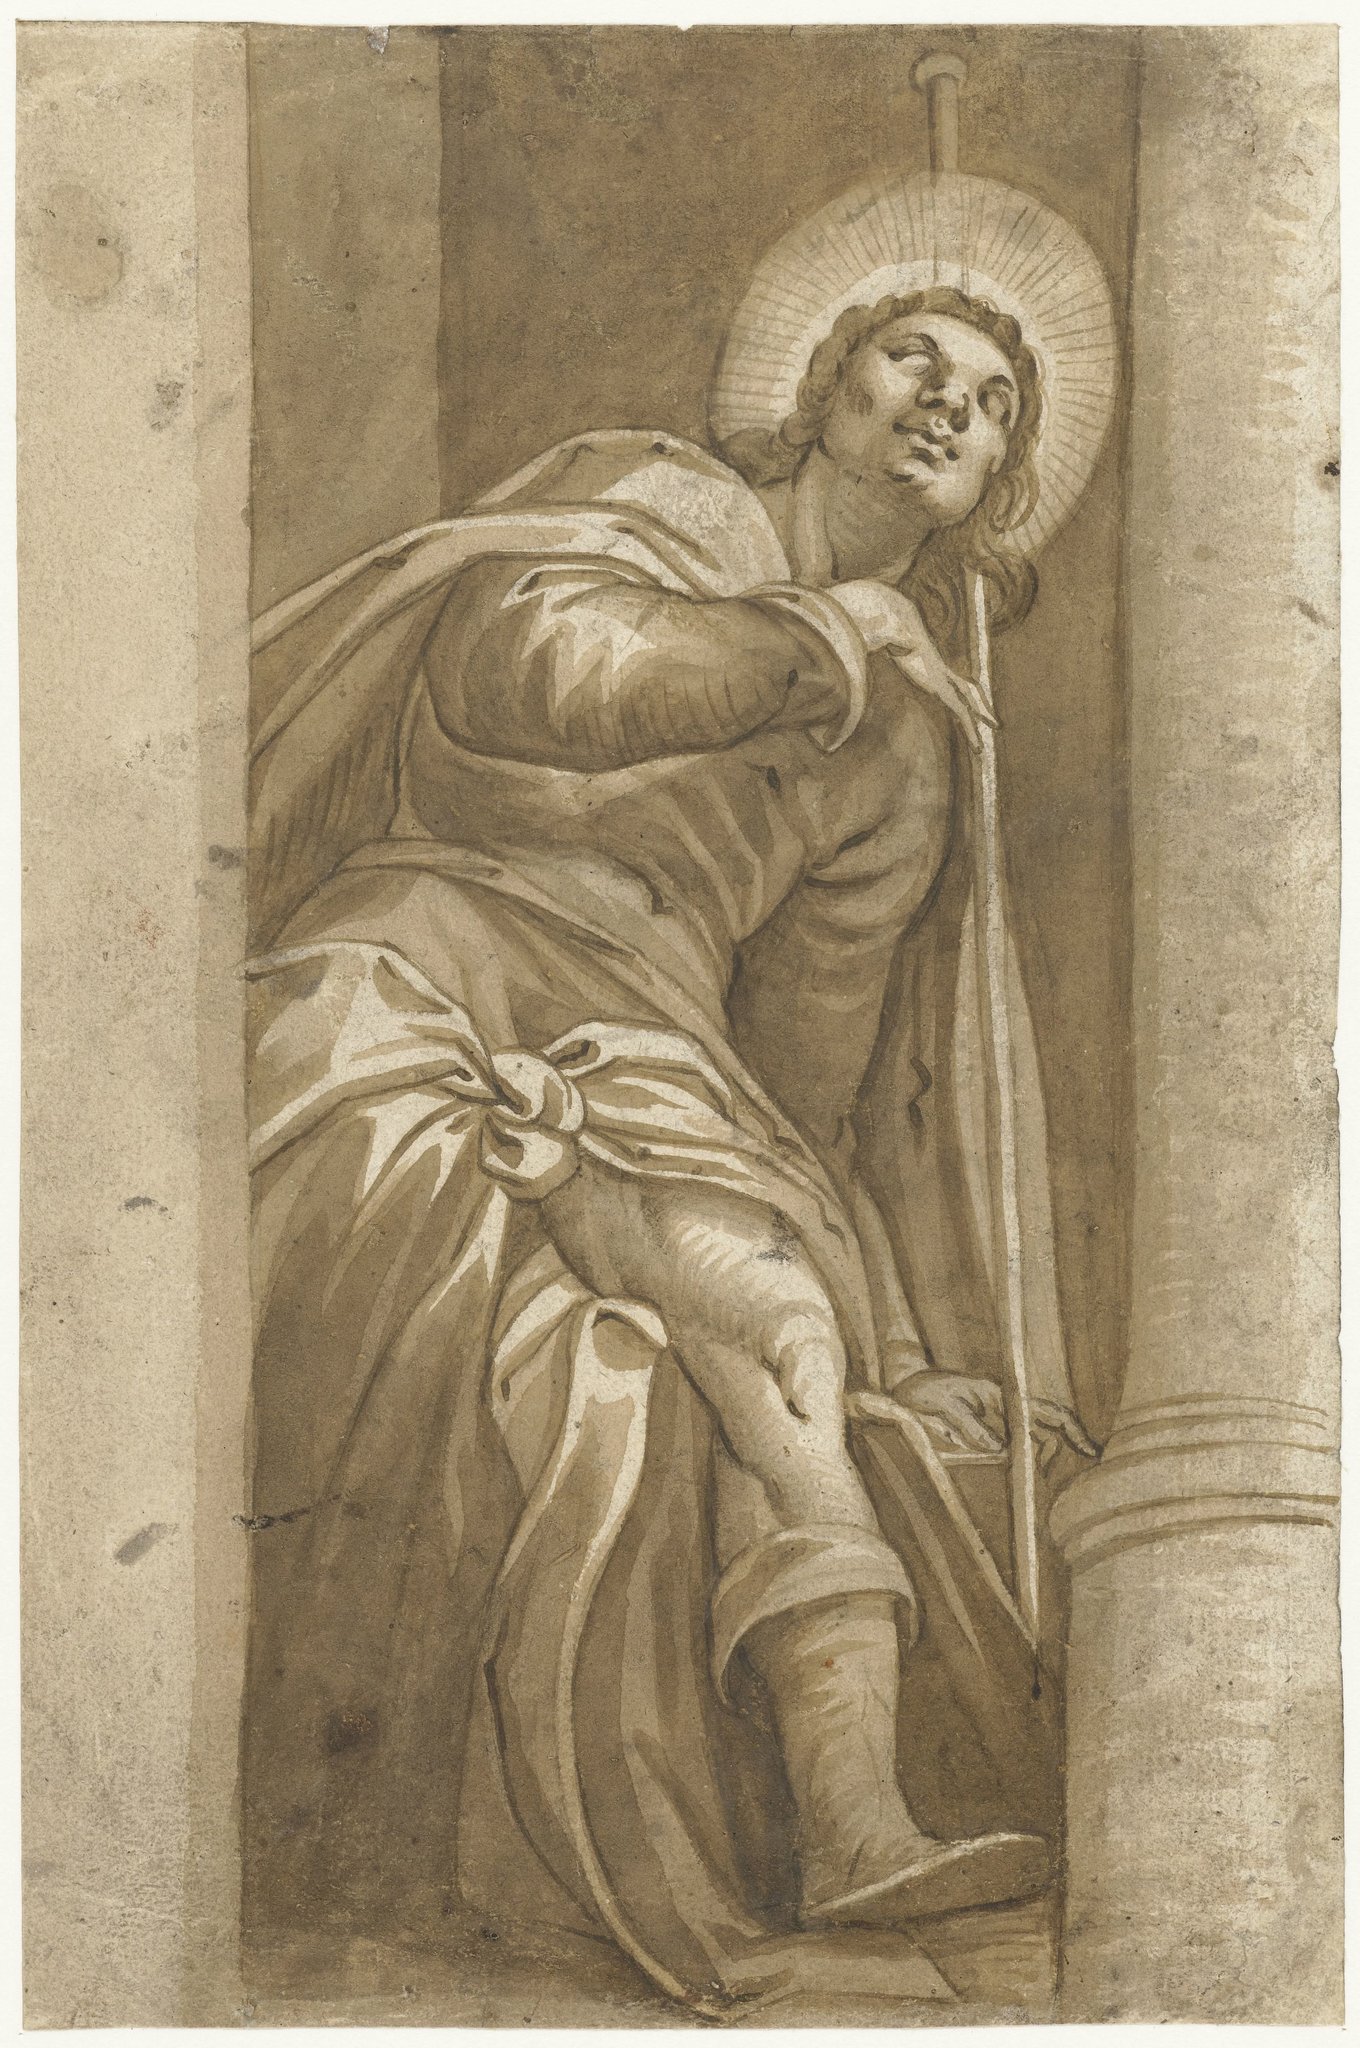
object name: drawing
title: De Heilige Rochus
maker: gerard ter borch (i)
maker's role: draughtsman, print maker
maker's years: 1584-1662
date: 1611-1612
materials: chalk, paint, gouache, ink, paper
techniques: brush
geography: italy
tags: the confessor and pilgrim roch(us) (rocco, rock) of montpellier; possible attributes: angel (with ointment box or spoon), dog (sometimes with loaf), (pointing at) plague-spot on thigh, pilgrim's shell, staff, hat and wallet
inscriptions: inscription: ‘GtB Sr; G. Ter Borch’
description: Naar een fresco van Tintoretto in de Sala Grande Superiore van de Scuola San Rocco.